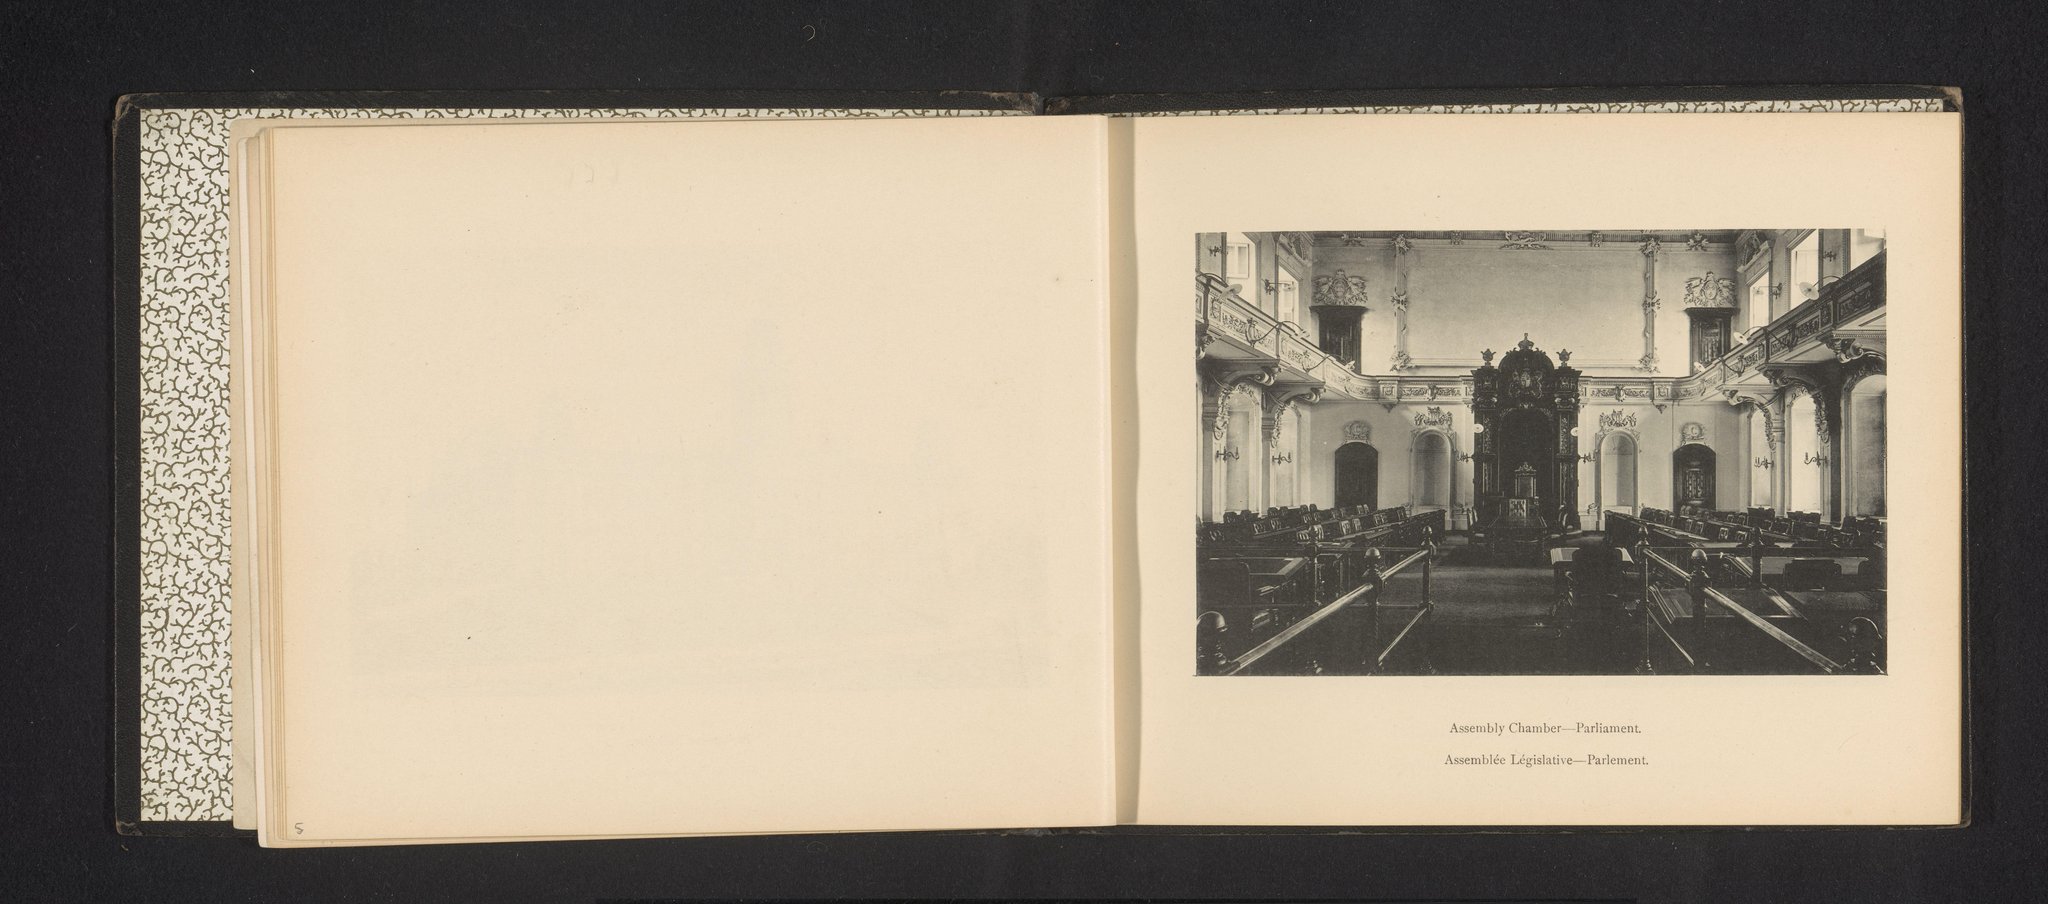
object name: photomechanical print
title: Assembly Chamber Parliament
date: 1889-1894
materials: paper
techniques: photograph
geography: quebec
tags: lower house, parliament, chamber, québec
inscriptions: inscription: ‘Assemblée Législative Parlement’